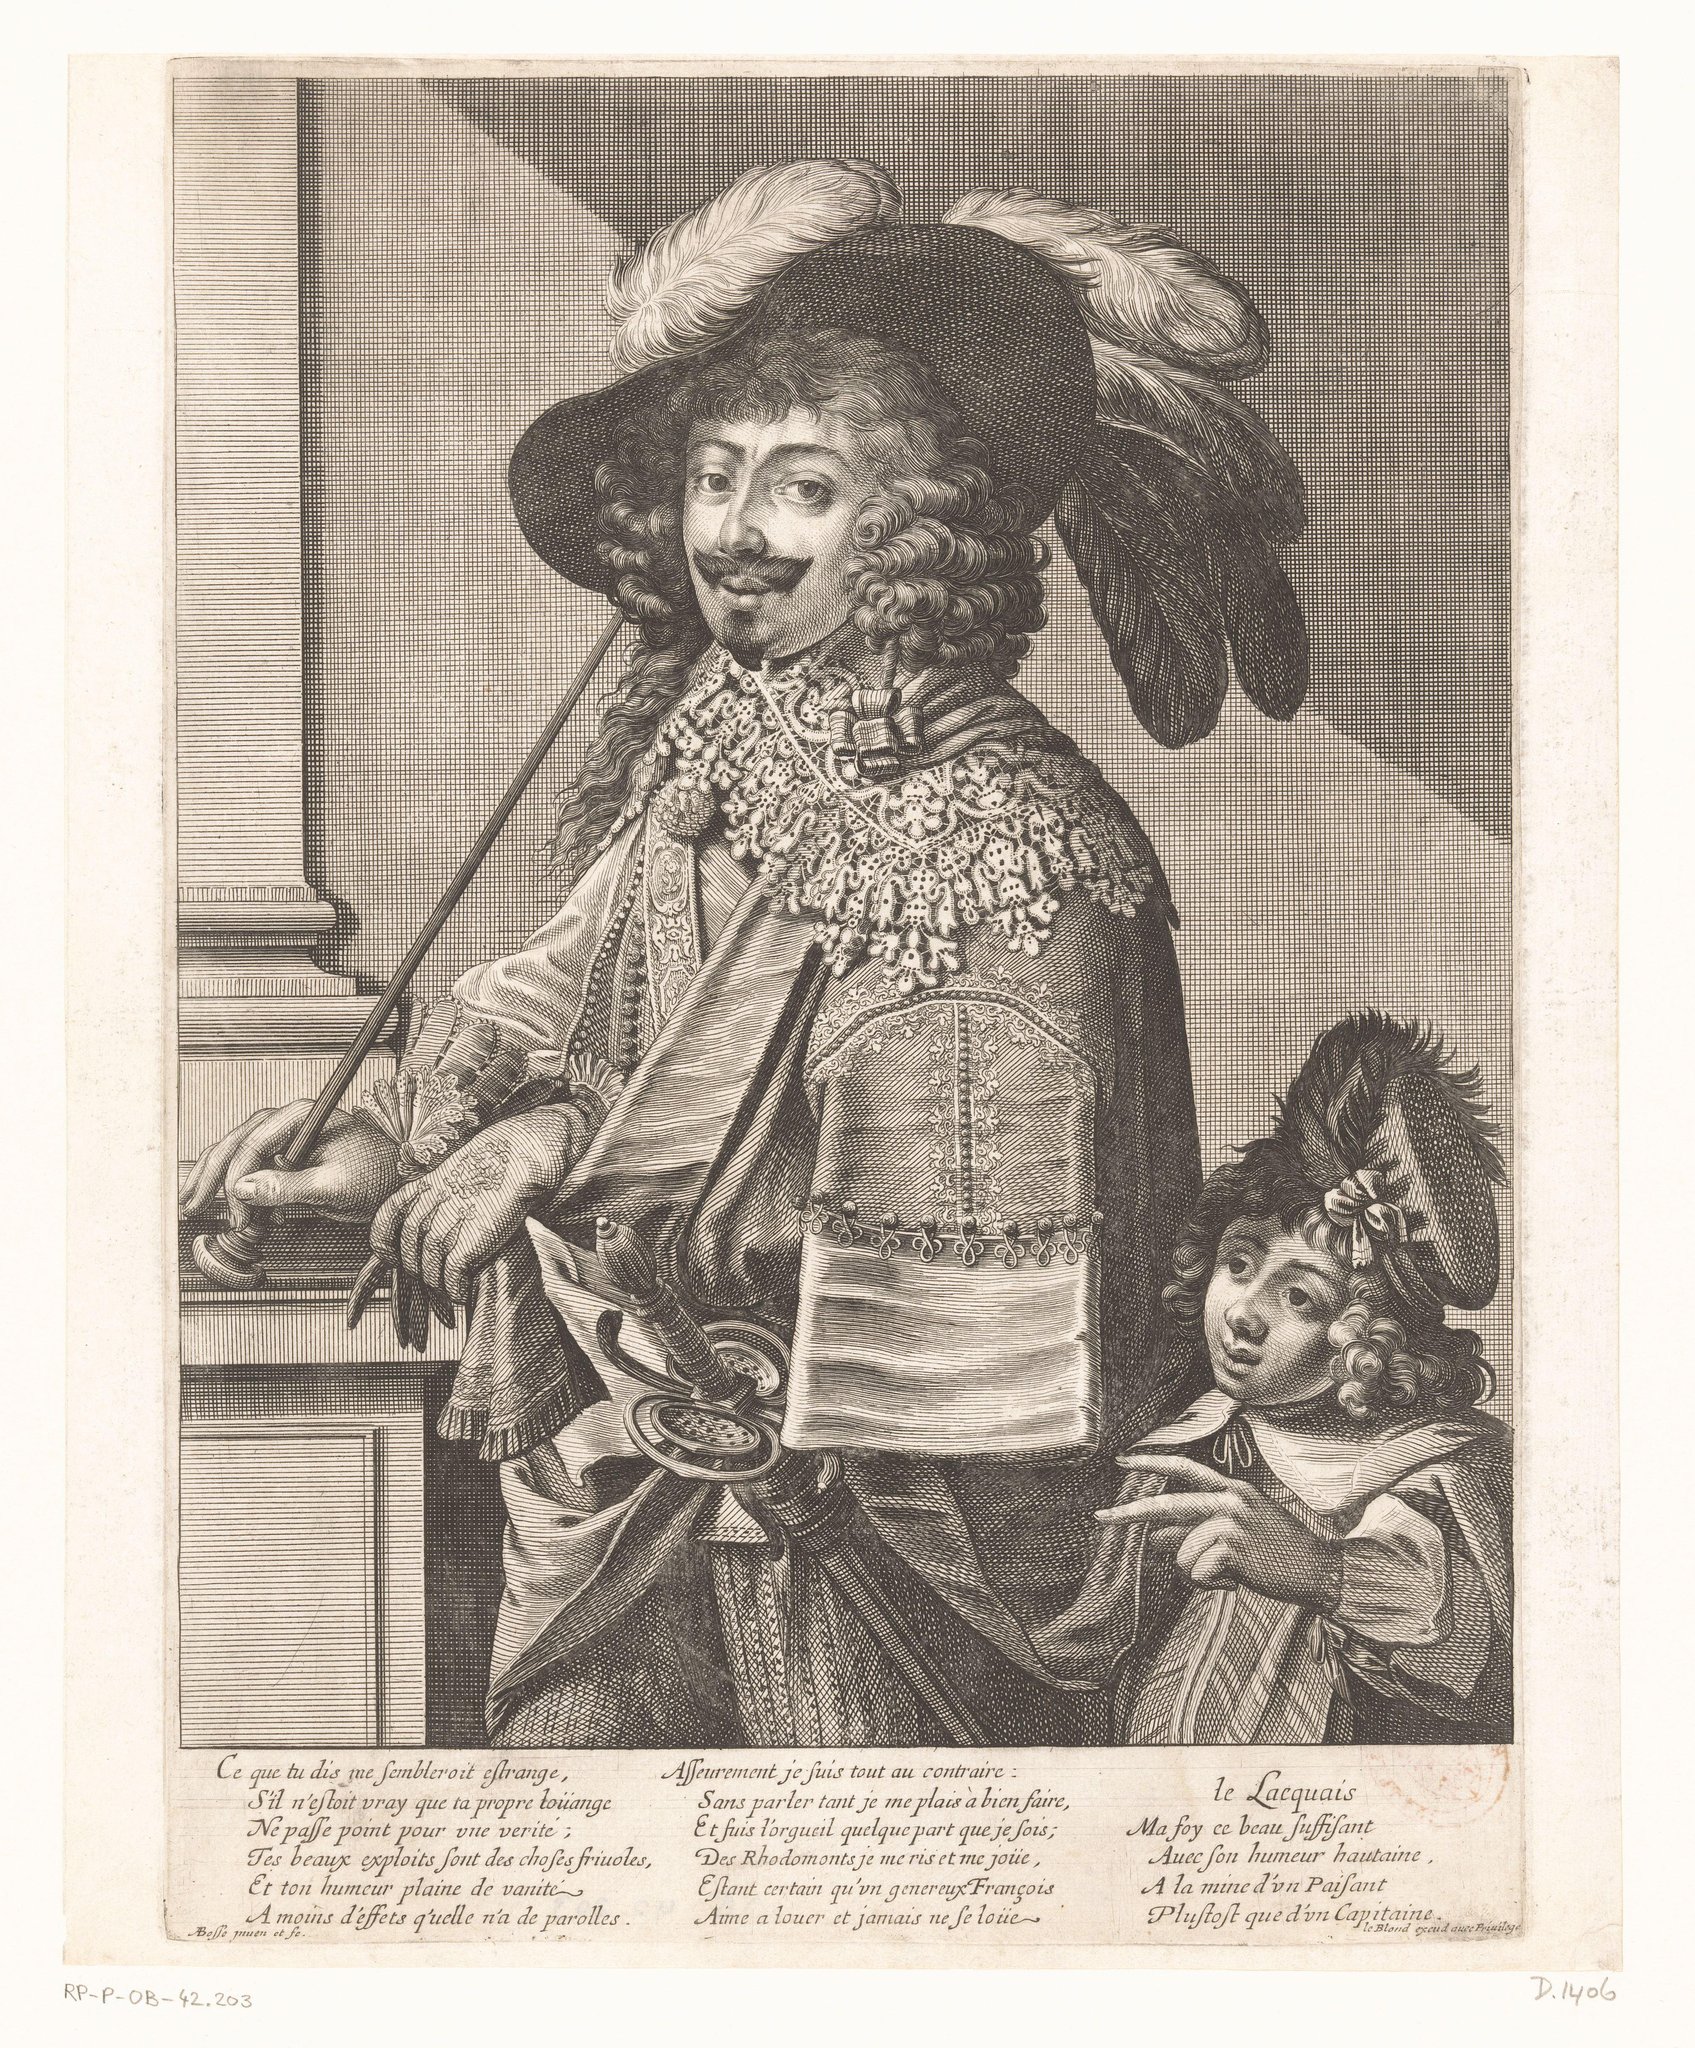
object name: print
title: Franse man met een lakei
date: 1635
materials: paper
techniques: engraving, etching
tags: lackey and other lower personnel at court, europeans (with name) (+ costume)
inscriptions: collector's mark: Lugt 240